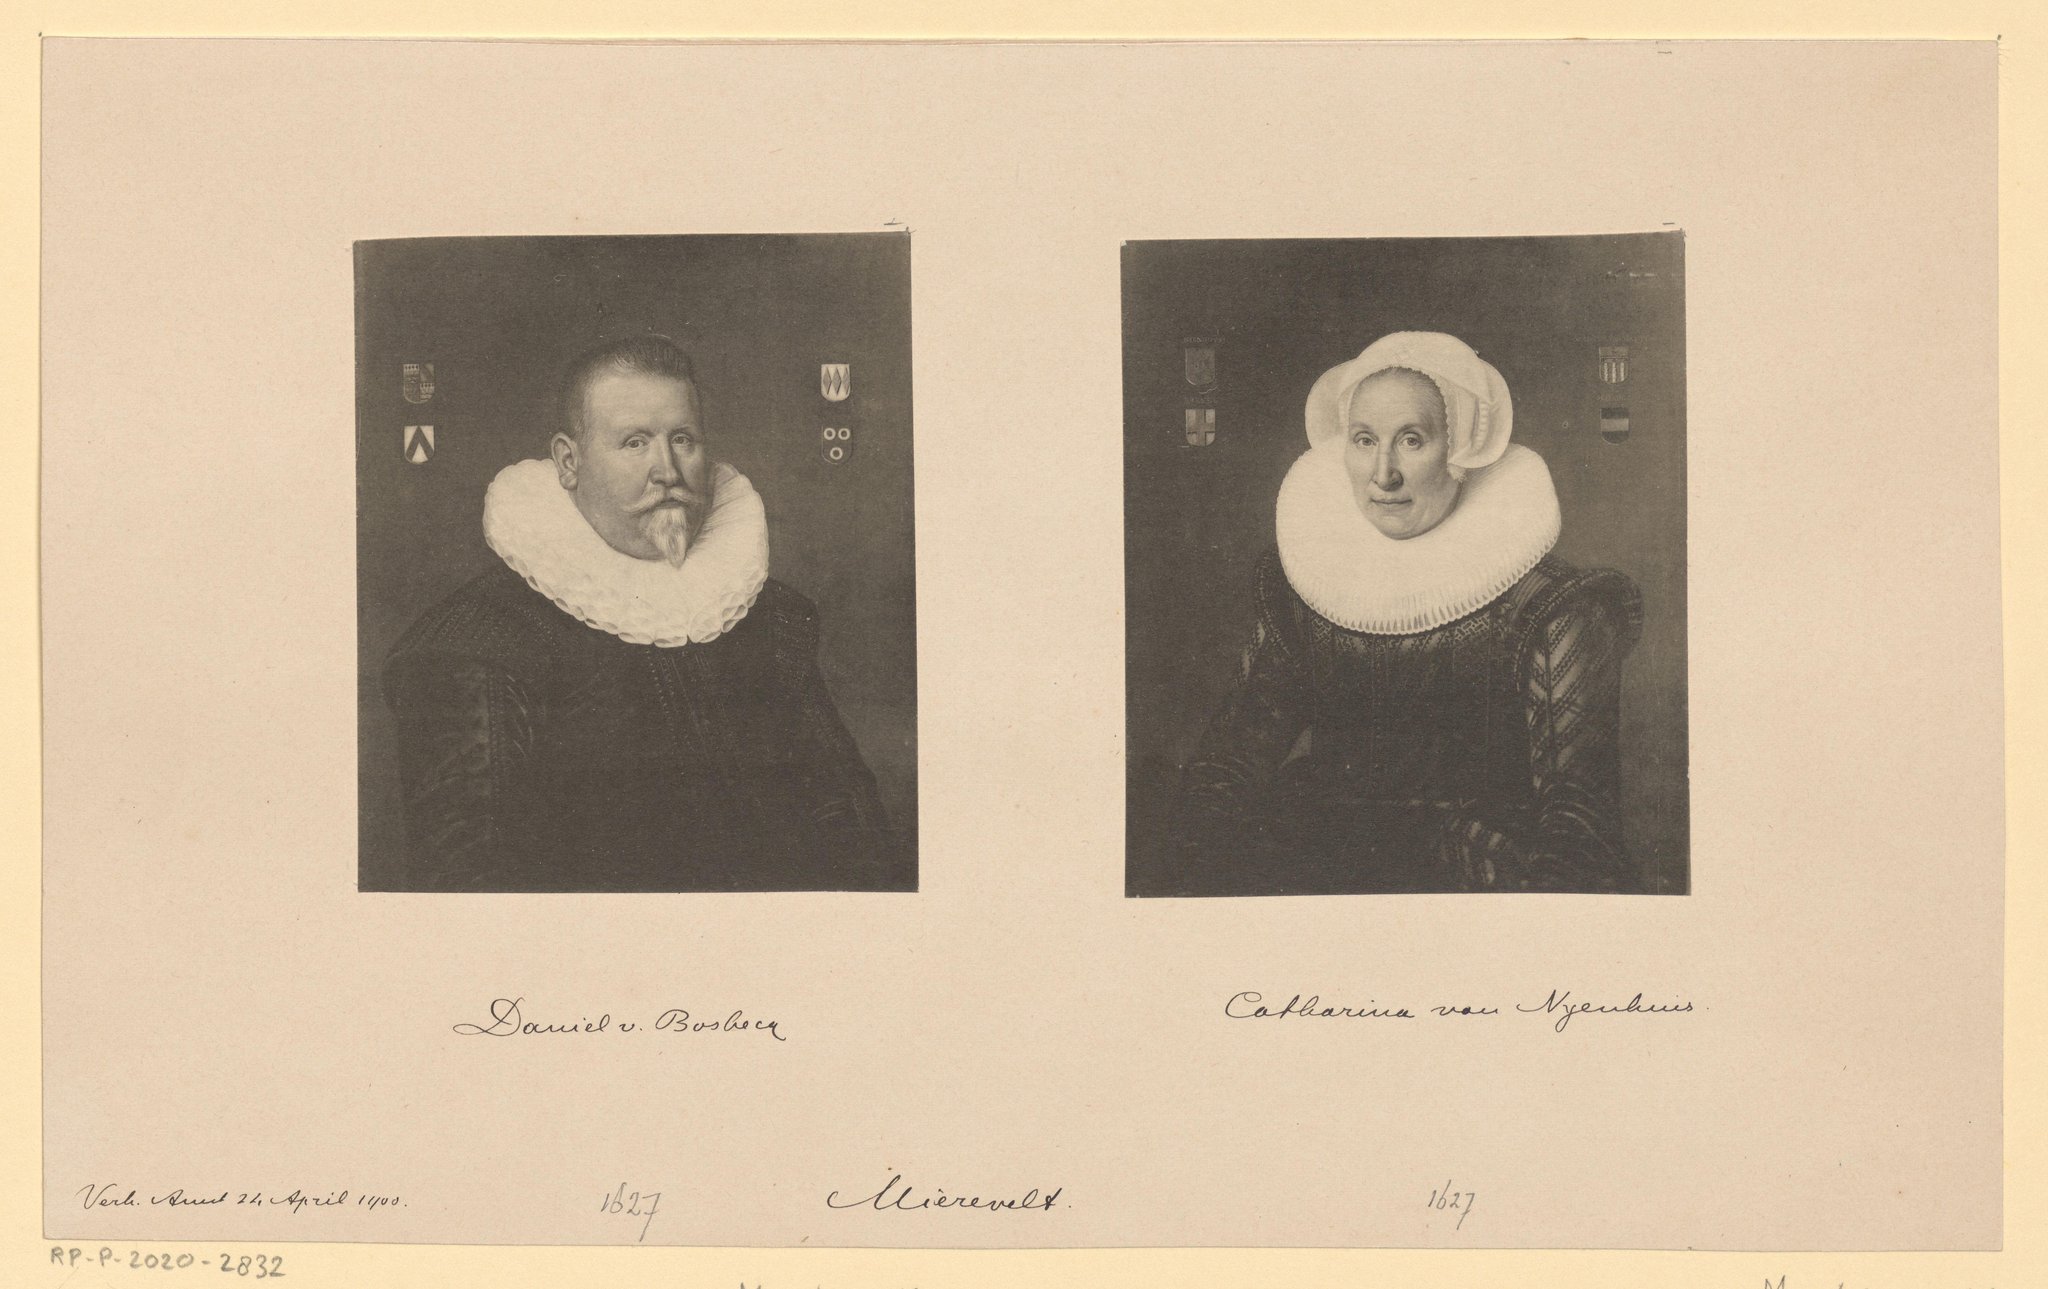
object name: photomechanical print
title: Dubbelportret van een man en vrouw, mogelijk Daniel van Bosbeek en Catharina van Nyenhuis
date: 1875-1930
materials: paper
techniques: photograph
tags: historical persons - bb - woman, historical persons, armorial bearing, heraldry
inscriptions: inscription: ‘Daniel v. Bosbeek Catharina van Nyenhuis. Verk. [...] 24 April 1900. Mierevelt.’